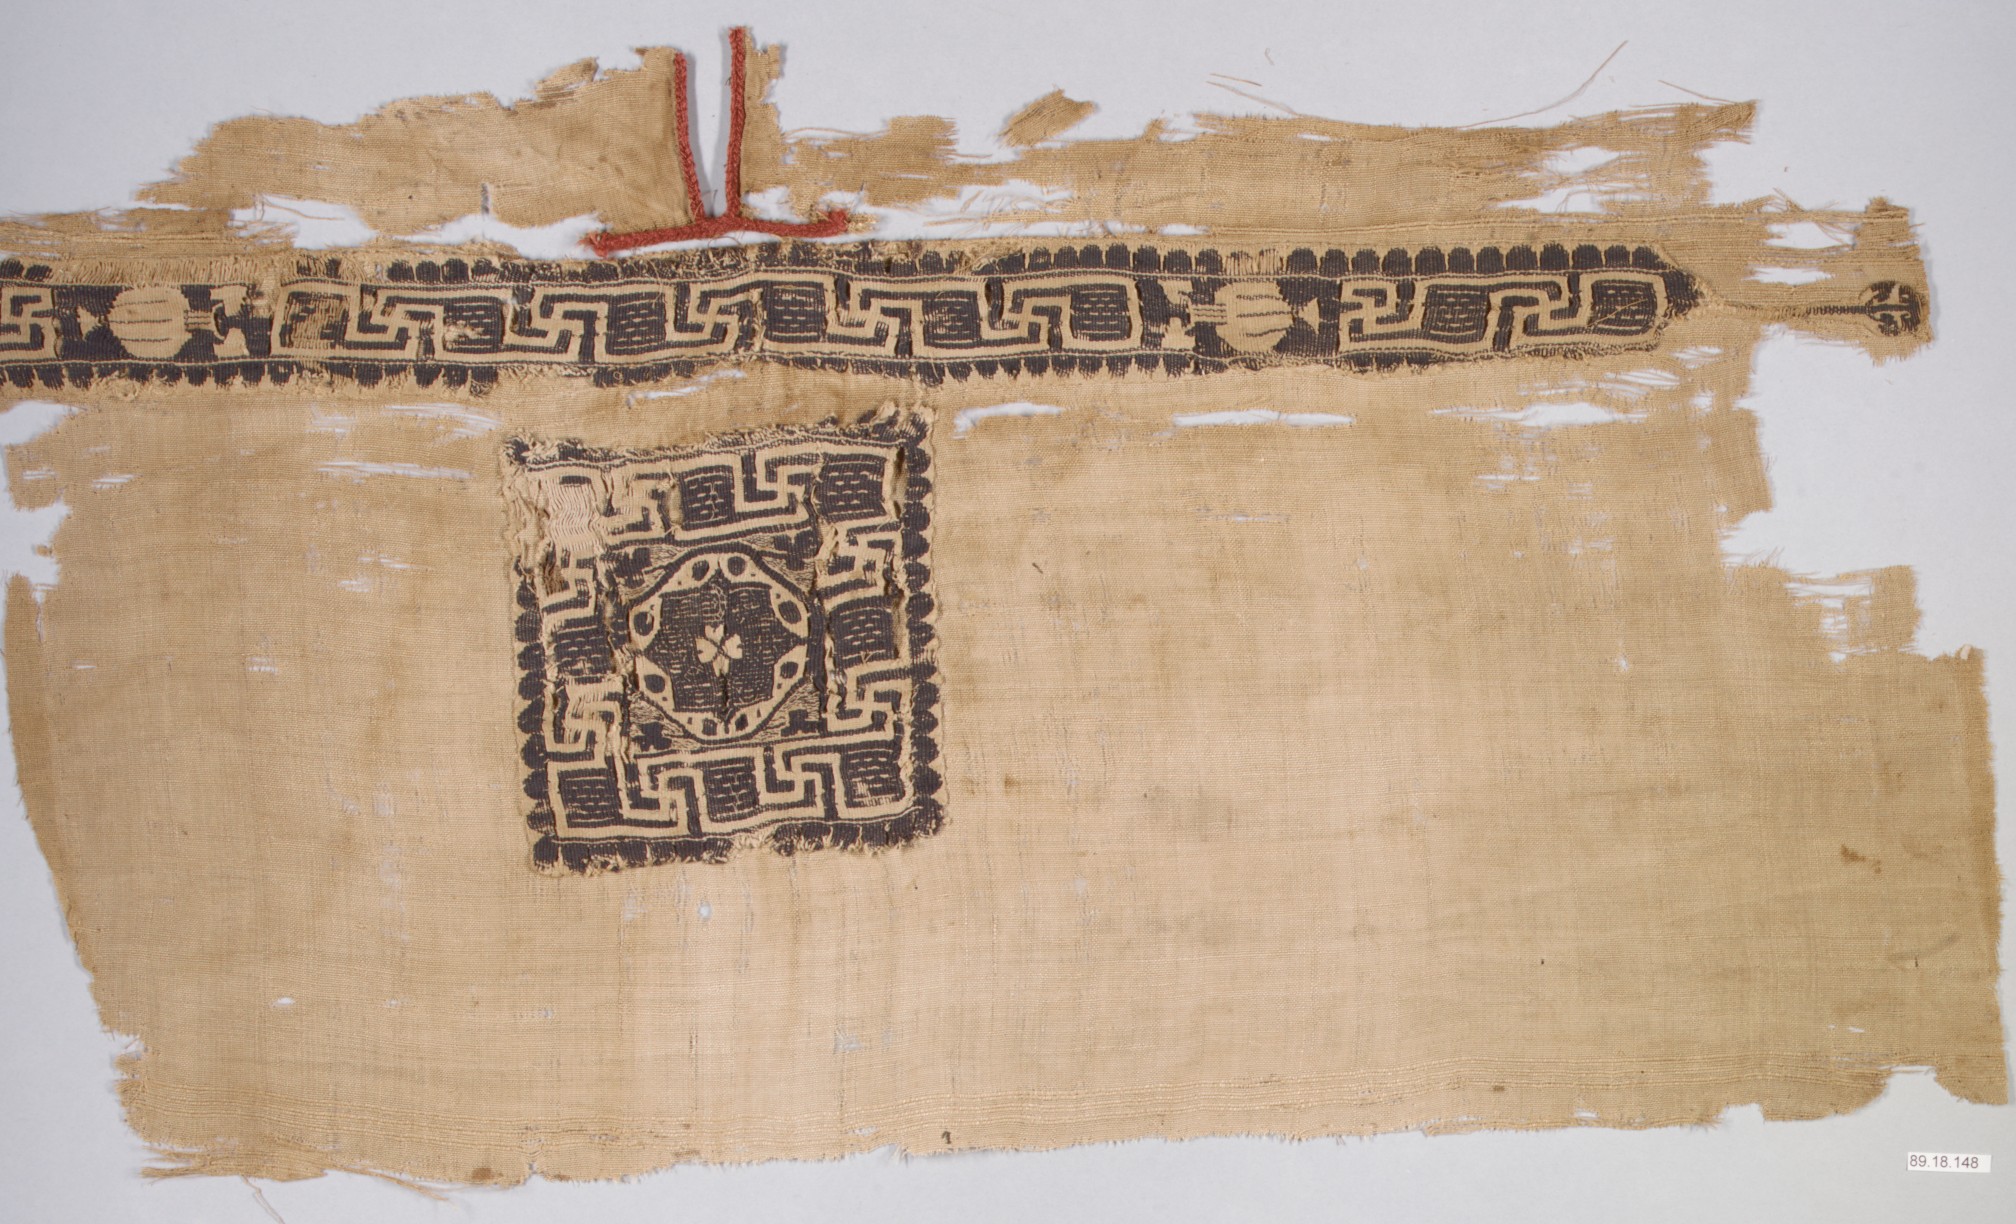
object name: textile fragment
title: Fragment of a Tunic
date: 201-400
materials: linen, wool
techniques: weave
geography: egypt